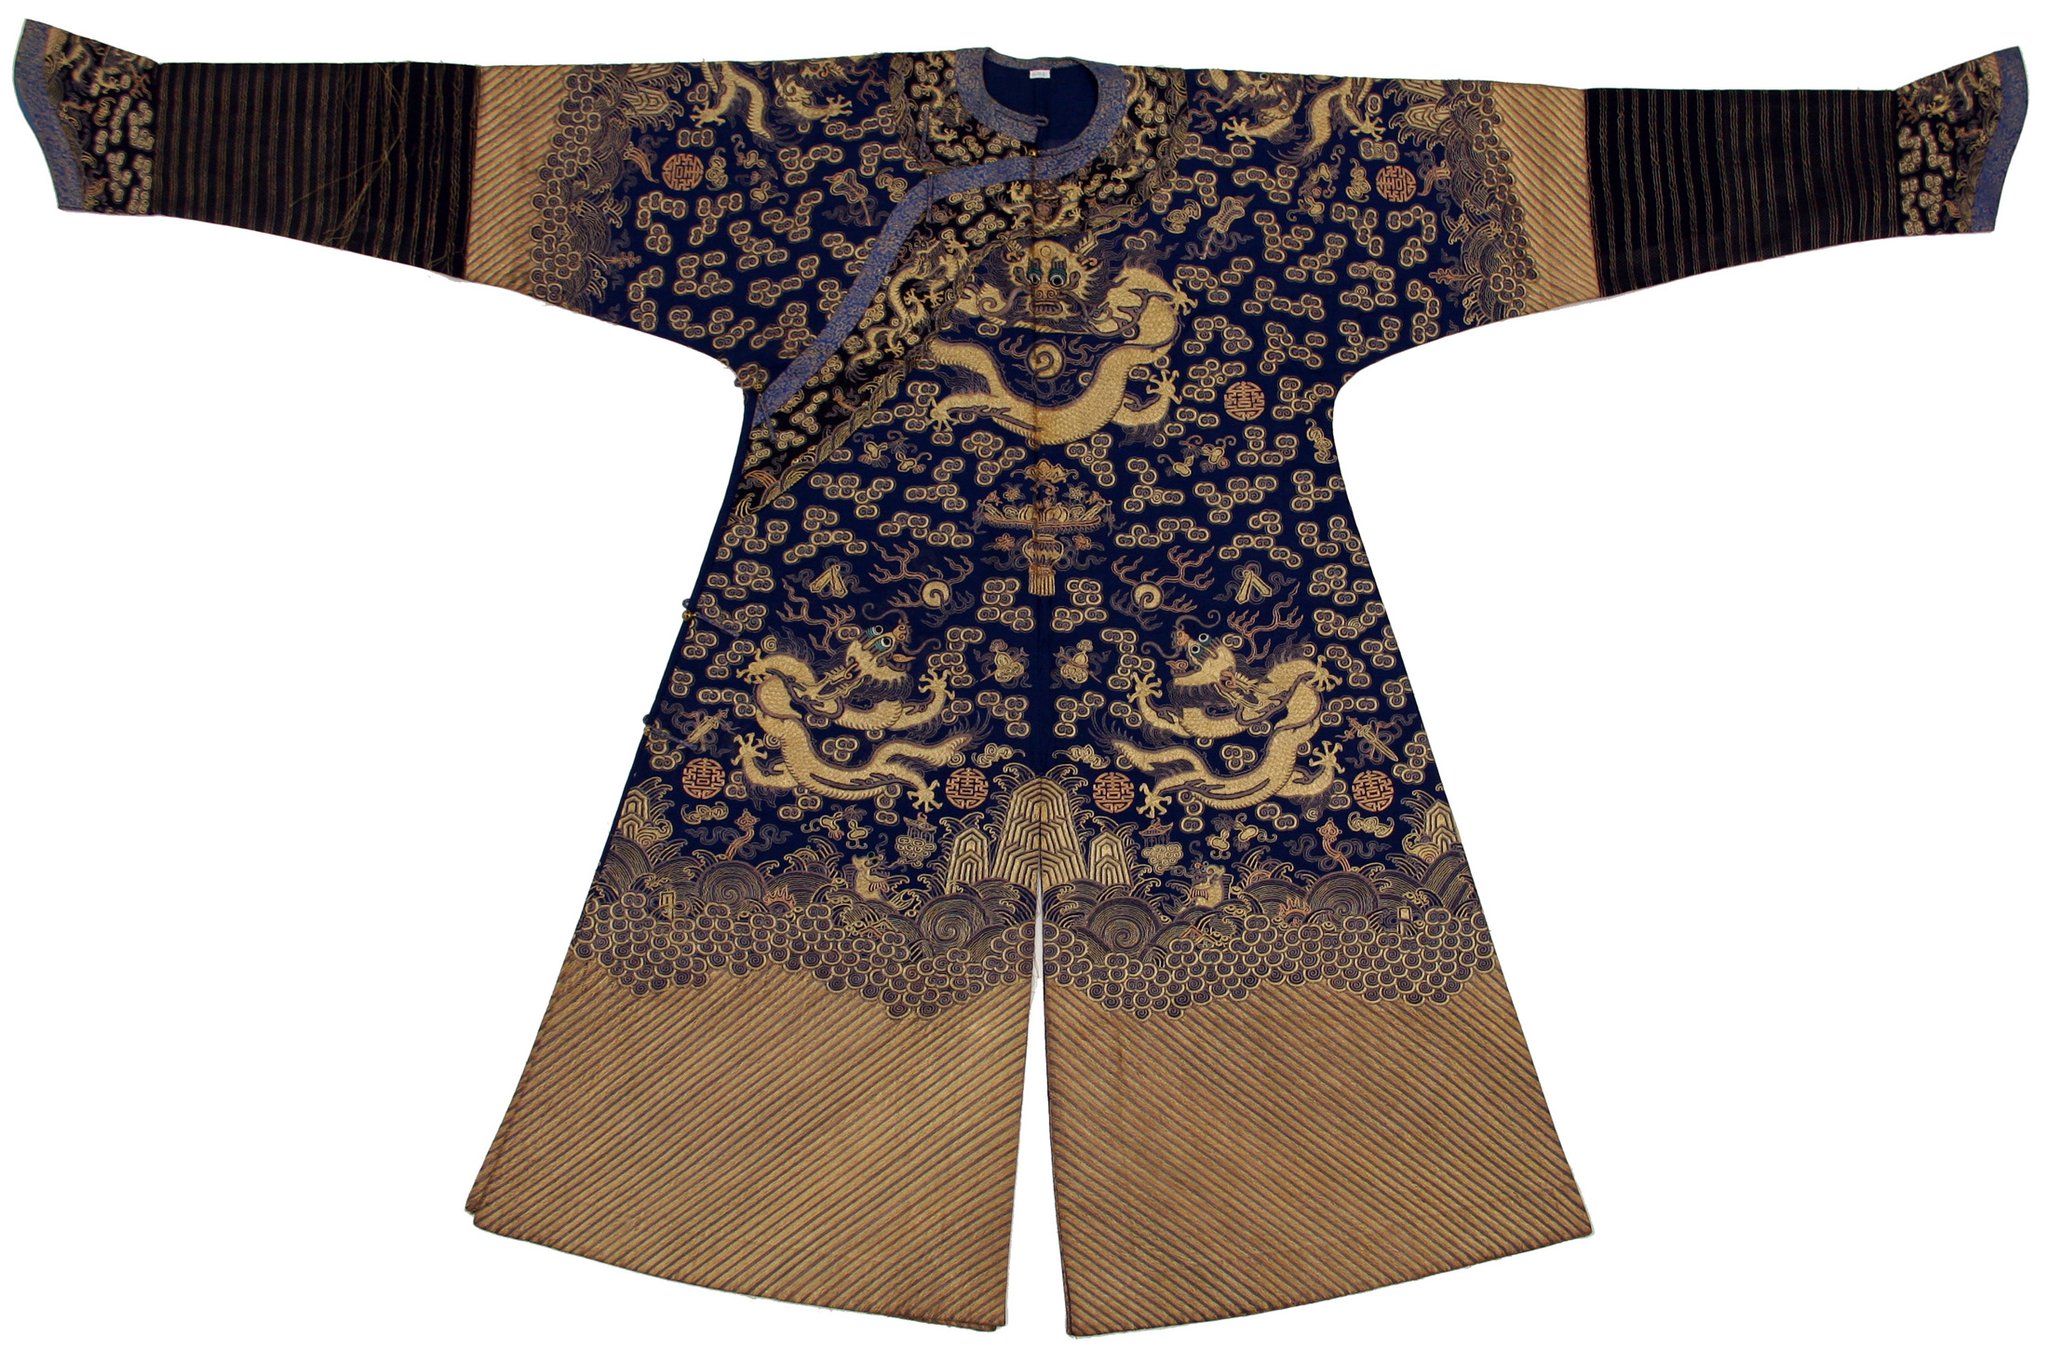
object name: robe, court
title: Court Robe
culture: chinese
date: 1801-1900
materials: metal thread, silk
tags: dragons